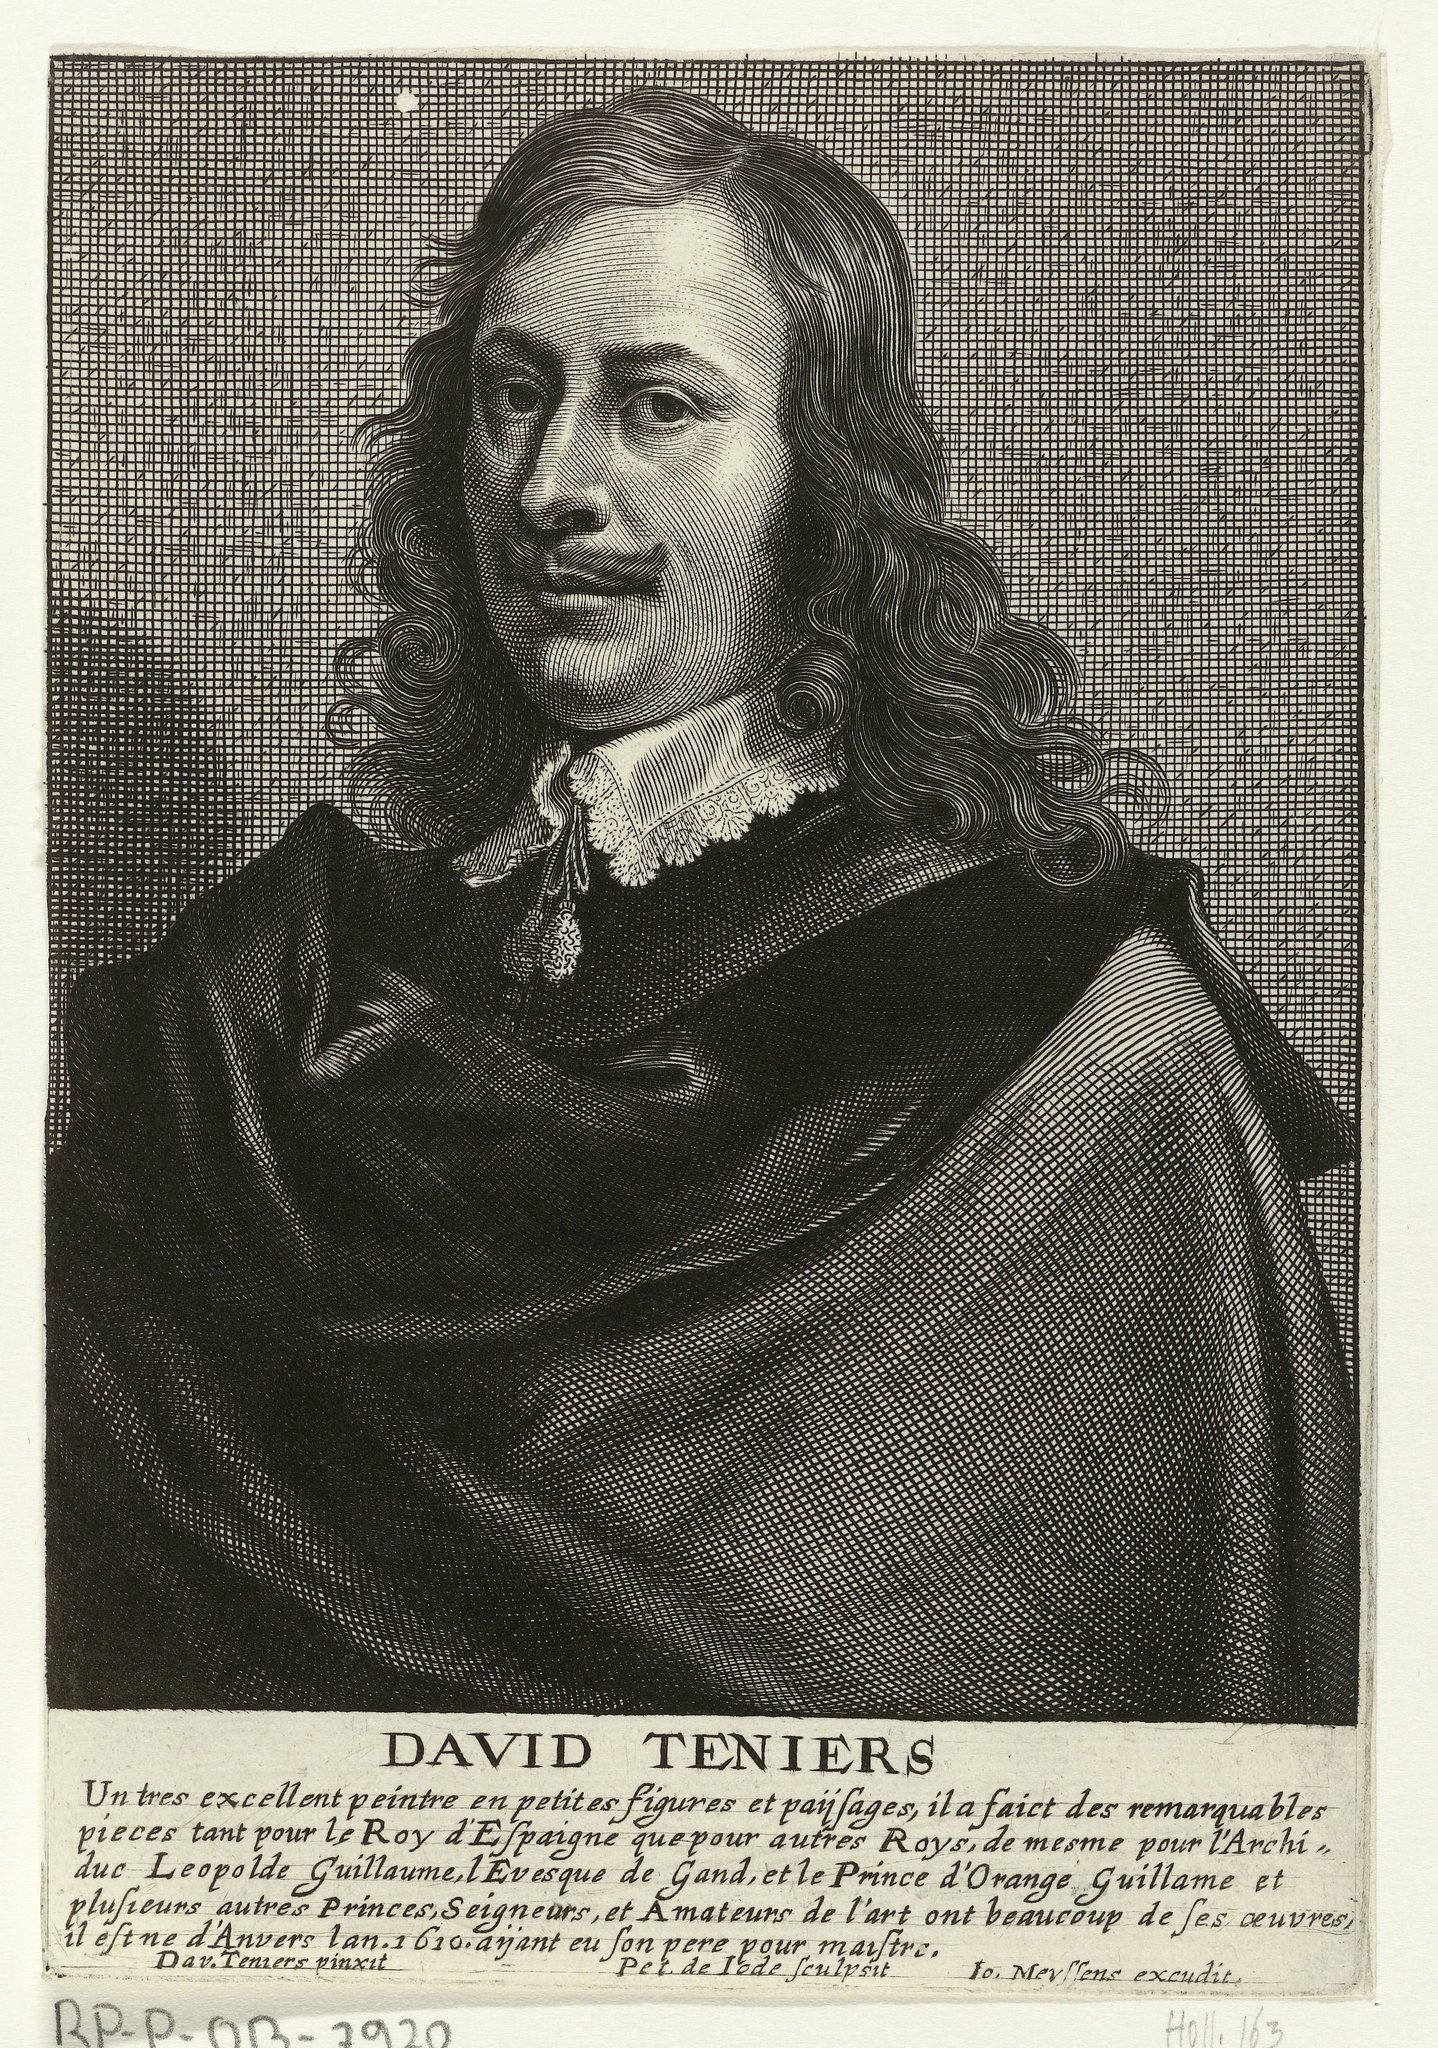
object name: print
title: Portret van David Teniers II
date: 1649-1662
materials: paper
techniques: engraving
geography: antwerp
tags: antwerp, brussels, painter, print maker, draughtsman, david teniers (ii), historical persons, portrait, self-portrait of painter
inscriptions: collector's mark: Lugt 2228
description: Prent gebruikt in: Bie, Cornelis De. Het gulden Cabinet vande edel vry schilder const, inhoudende den lof vande vermarste schilders, architecte, beldthowers ende plaetsnyders van dese eeuw. Antwerpen: Joannes Meyssens, 1662 [1661 foutief op titelpagina]. En mogelijk ook al in: Meyssens, Joannes. Image de divers hommes desprit sublime qui par leur art et science deburovent vivre eternellement et des quels la louange et renommée faict estonner le monde. 2 dln. Antwerpen: Joannes Meyssens, 1649. Tweede bekende staat (genummerd 79) gebruikt in: Resta, Sebastiano. The true effigies of the most eminent painters and other famous artists that have flourished in Europe. Londen, 1694. Derde bekende staat (genummerd 58) gebruikt in: The Portraits of the Most Eminent Painters, and other Famous Artists (...). Londen: Olive Payne, 1739.